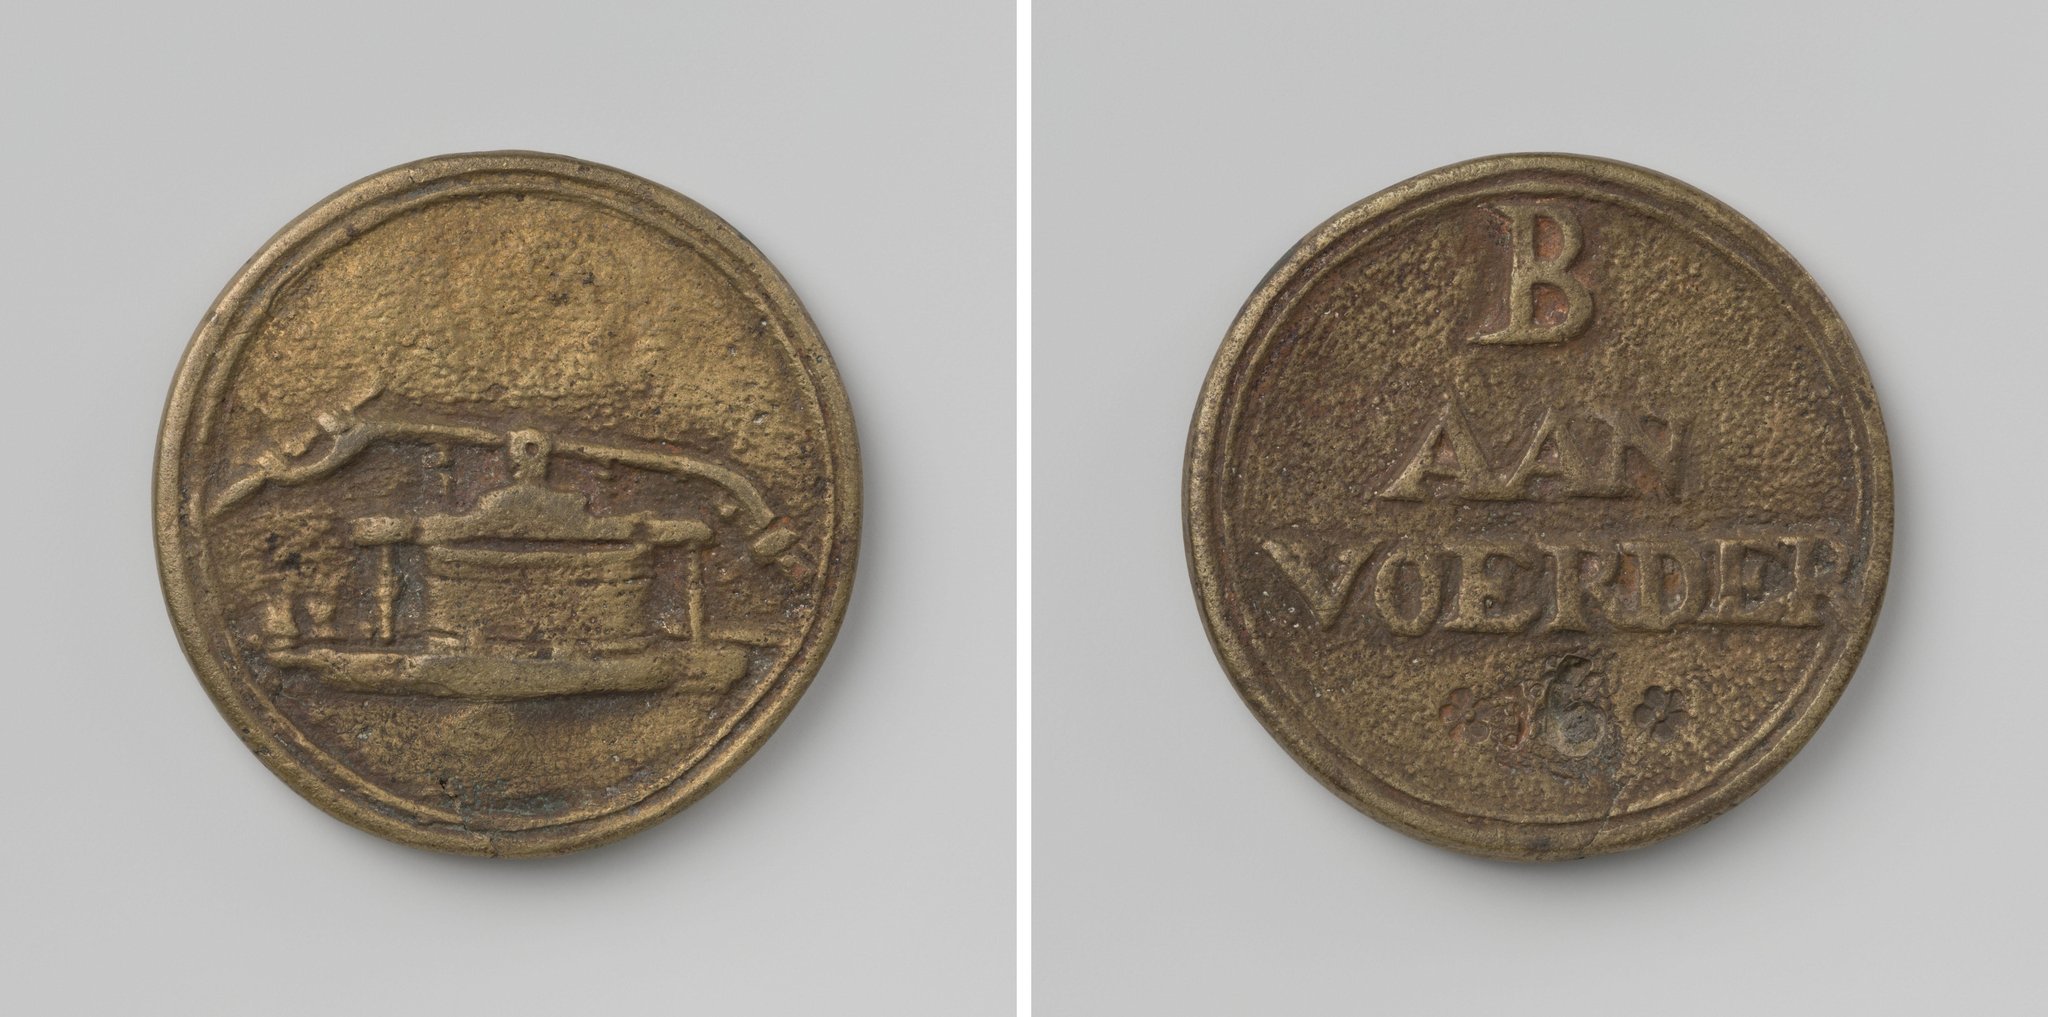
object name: fire engine medal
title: Enkhuizen, brandspuitpenning van de aanvoerder van spuit B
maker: Anonymous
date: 1680-1800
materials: brass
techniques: casting, engraving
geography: enkhuizen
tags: enkhuizen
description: Messing penning. Voorzijde: brandspuit boven uitgewist cijfer tussen twee rozetten. Keerzijde: opschrift